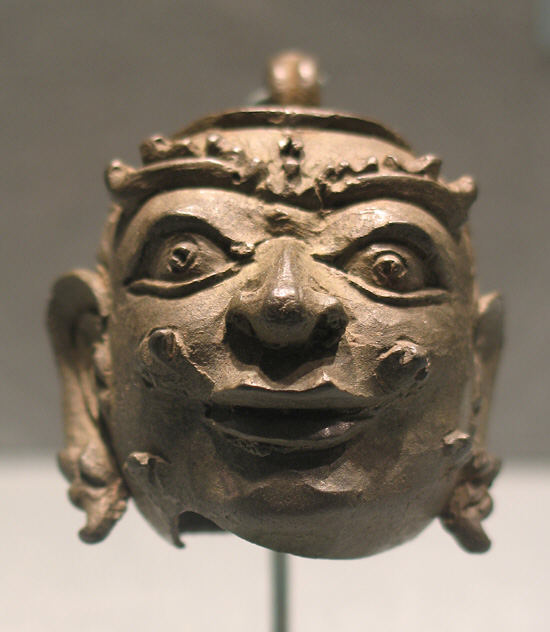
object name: bell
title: Pellet Bell in the Form of a Human Head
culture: indonesian, javanese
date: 1201-1400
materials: bronze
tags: heads